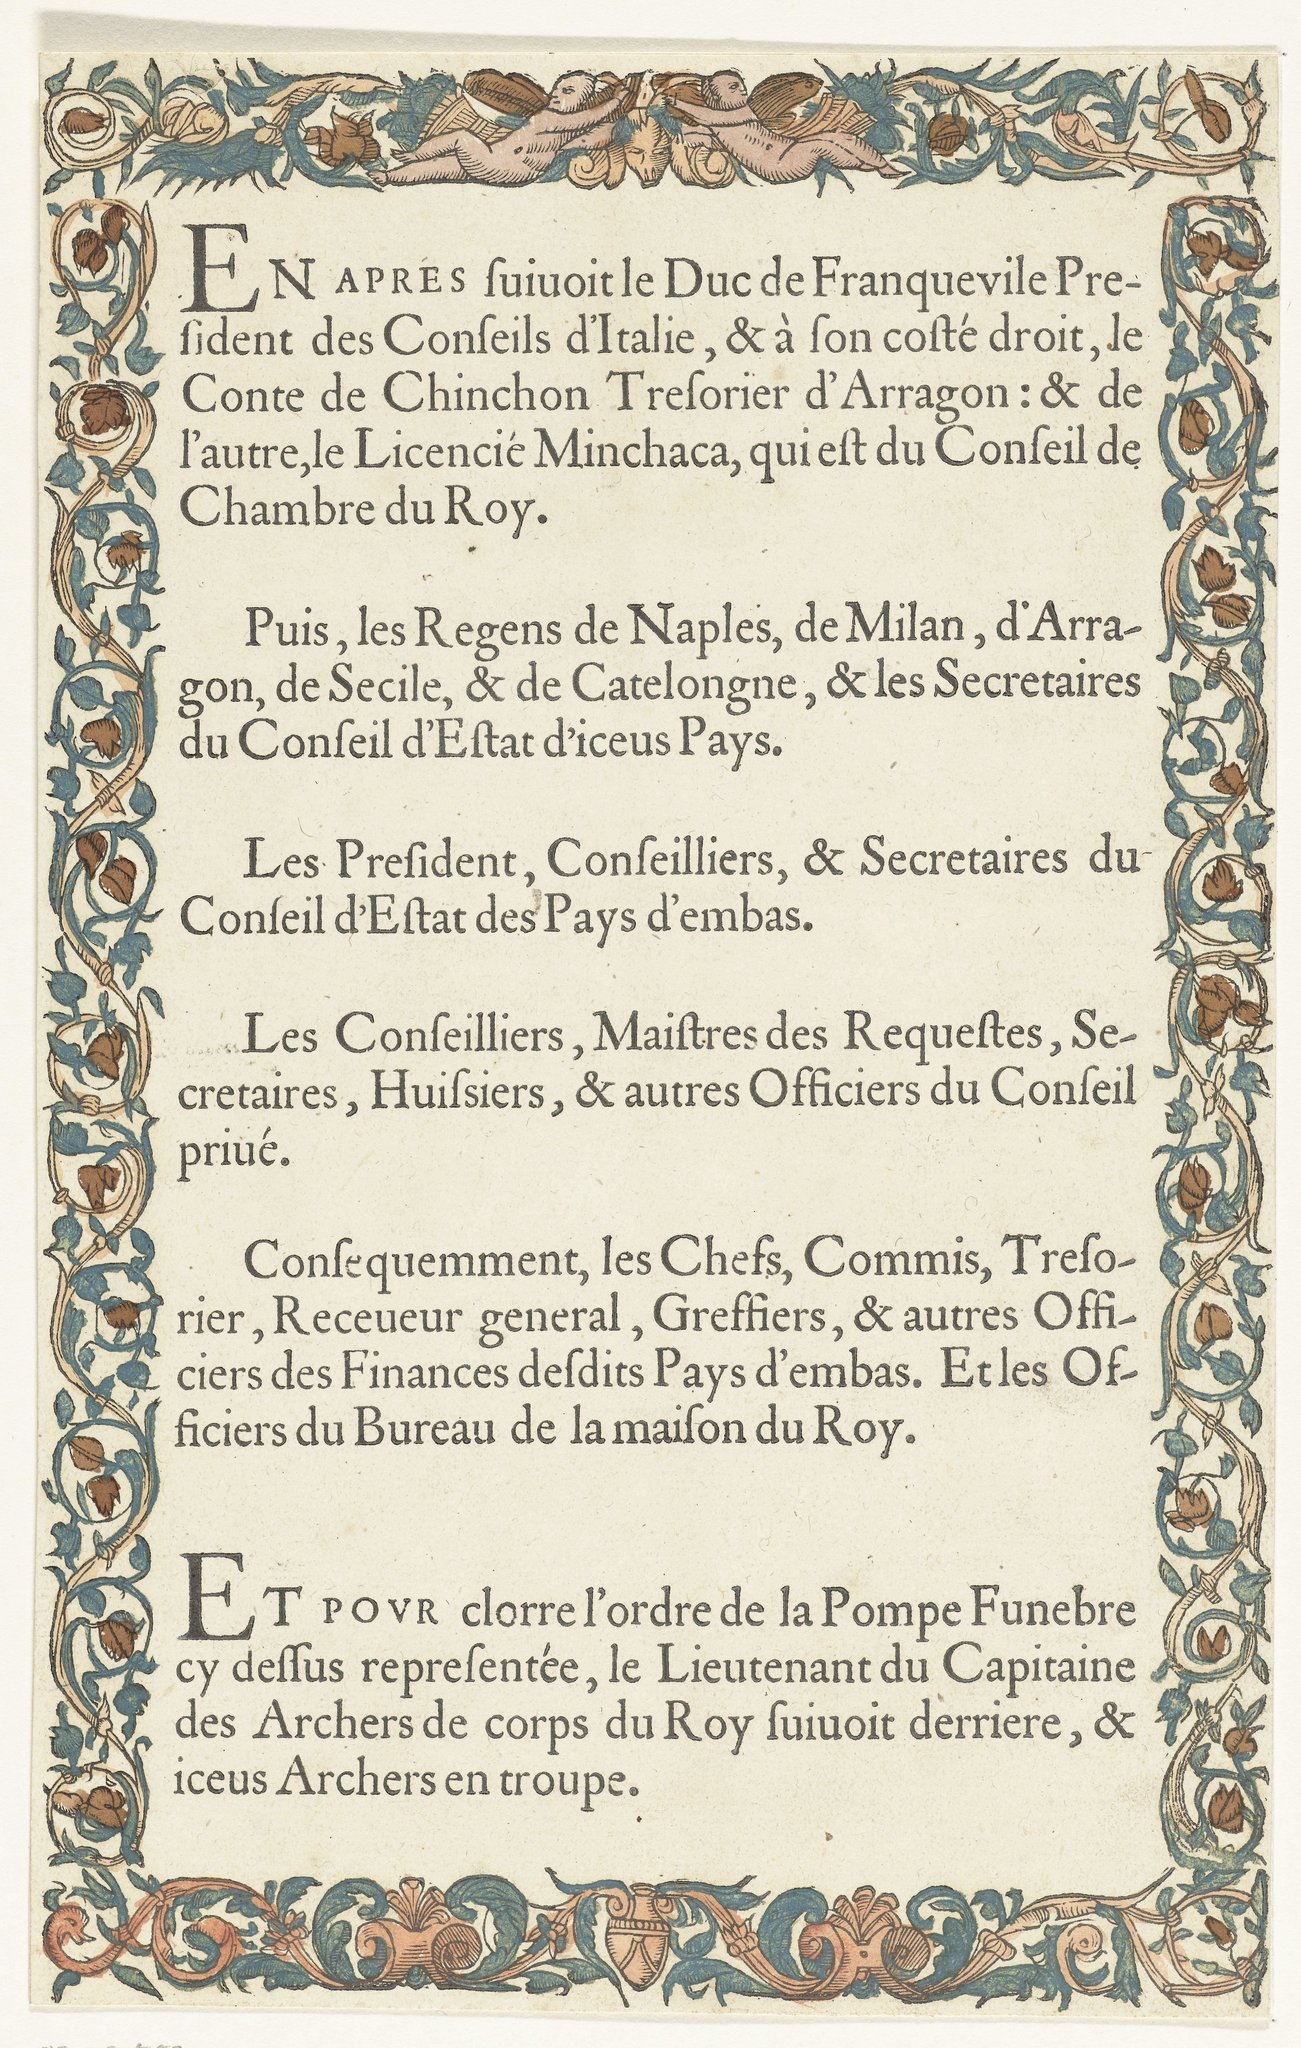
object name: text sheet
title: La magnifique, et sumptueuse Pompe Funebre, faite aus Obseques & Funerailles du tres-grand & tres-victorieus Empereur Charles Cinquième, Celebrées en la Vile de Bruxelles le XXIX. Iour du Mois de Decembre M.D.LVIII. par Philippes Roy Catholique d'Espaignes son Fils.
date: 1559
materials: paper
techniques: hand coloring, letterpress printing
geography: antwerp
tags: ghent, charles v (holy roman emperor and king of spain), brussels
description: Tekstblad bij de Begrafenisoptocht van keizer Karel V, 1558. Tekstblad met titel en beschrijving van de optocht. In ornamentele randen in houtsnede. Vijfde blad.